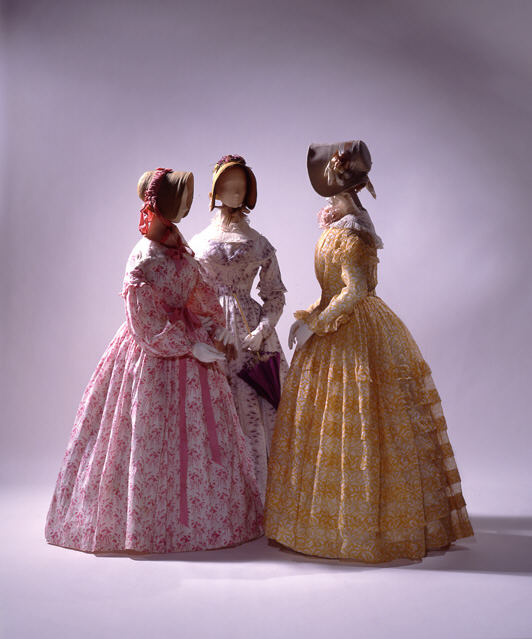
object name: morning dress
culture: american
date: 1838-1840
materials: cotton